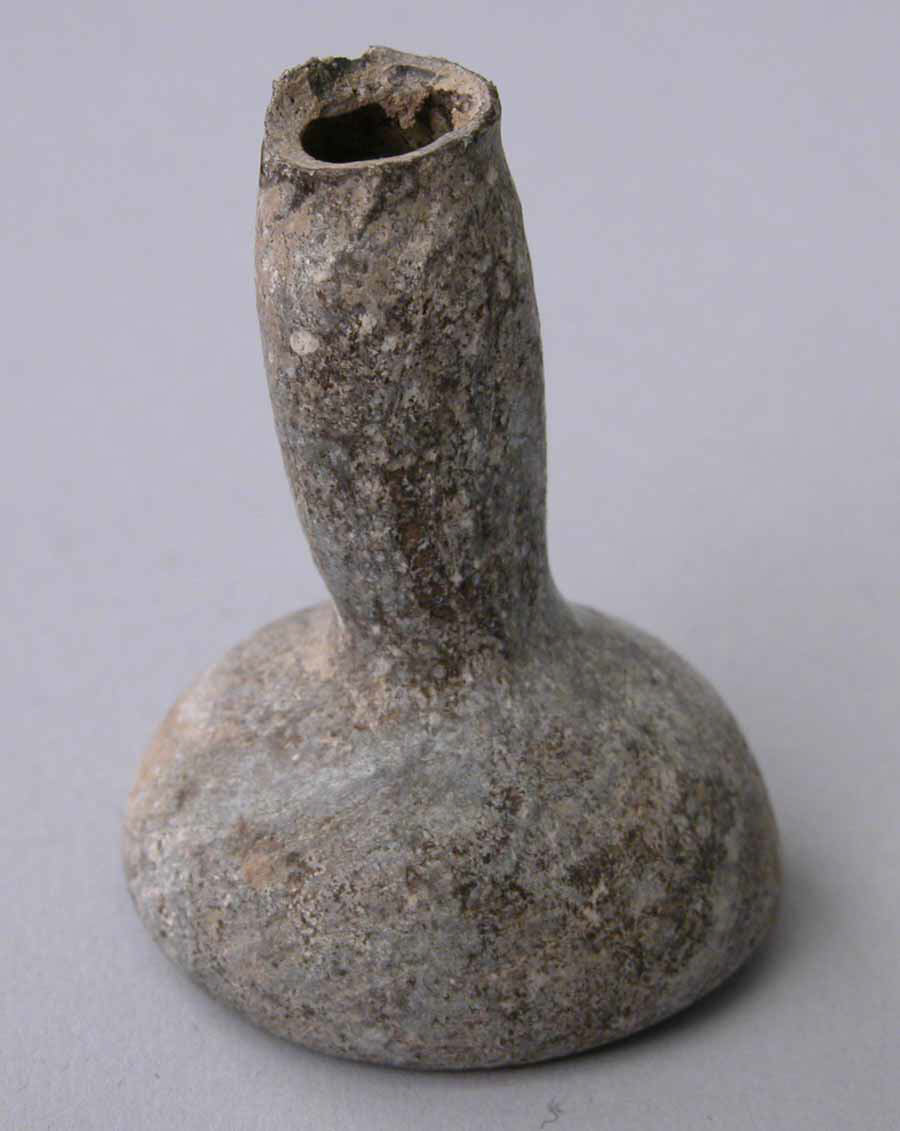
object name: bottle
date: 601-800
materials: glass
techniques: glassblowing, tooling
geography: iraq